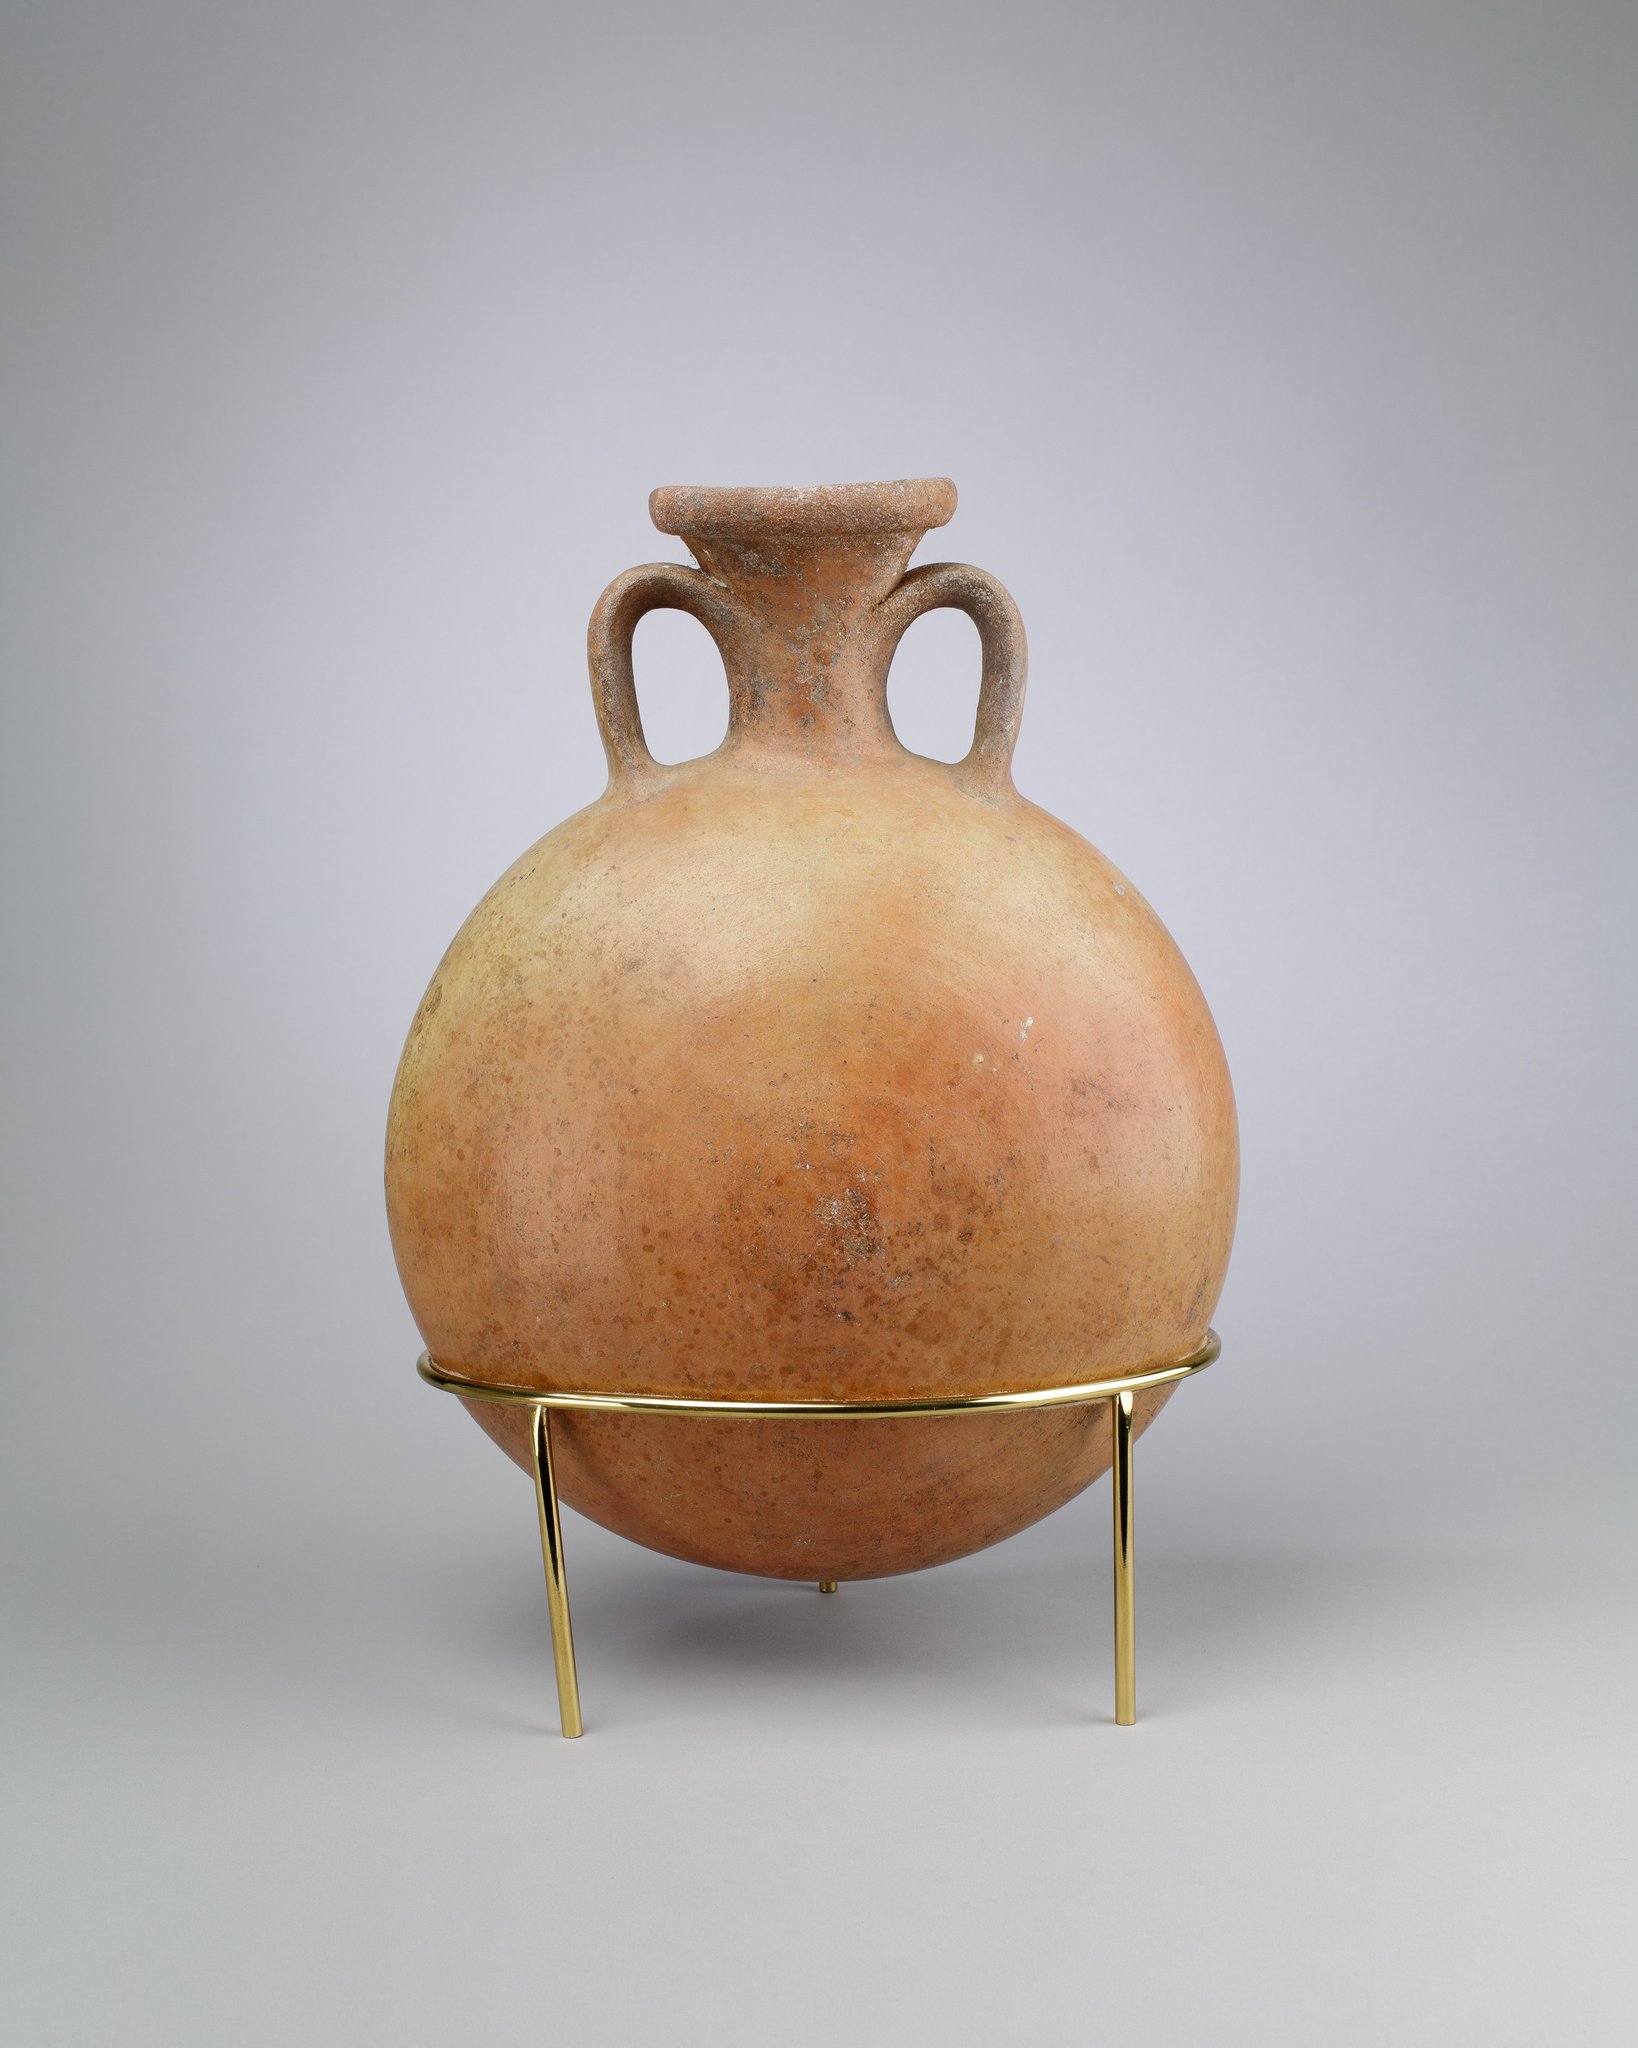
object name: bottle, 'pilgrim flask'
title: Lentoid Bottle (Pilgrim Flask)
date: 1353-1336 BCE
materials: pottery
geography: egypt